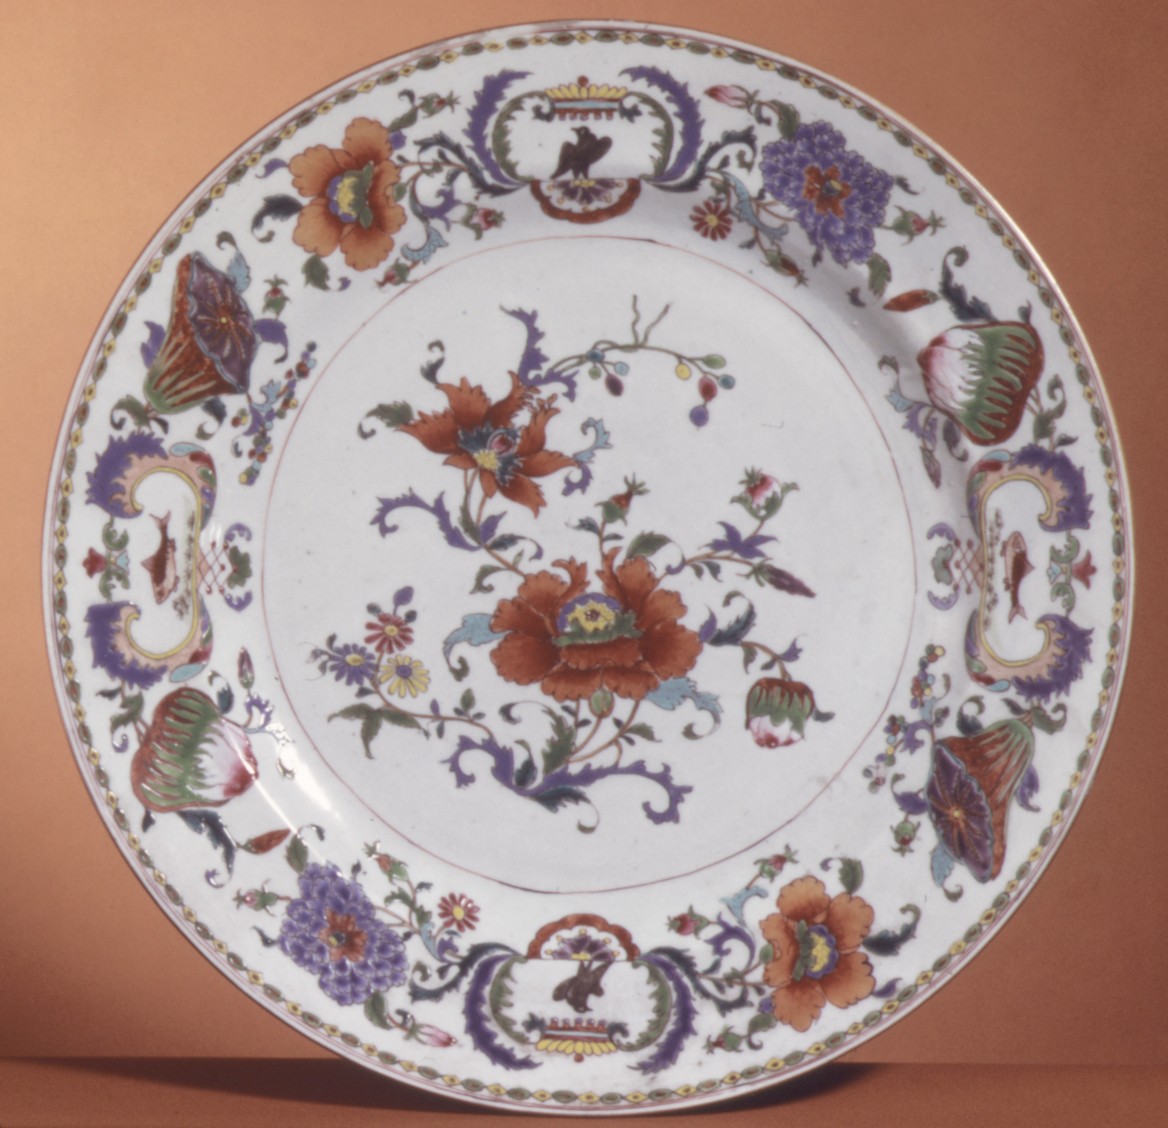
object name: dish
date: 1735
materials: hard paste porcelain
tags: flowers